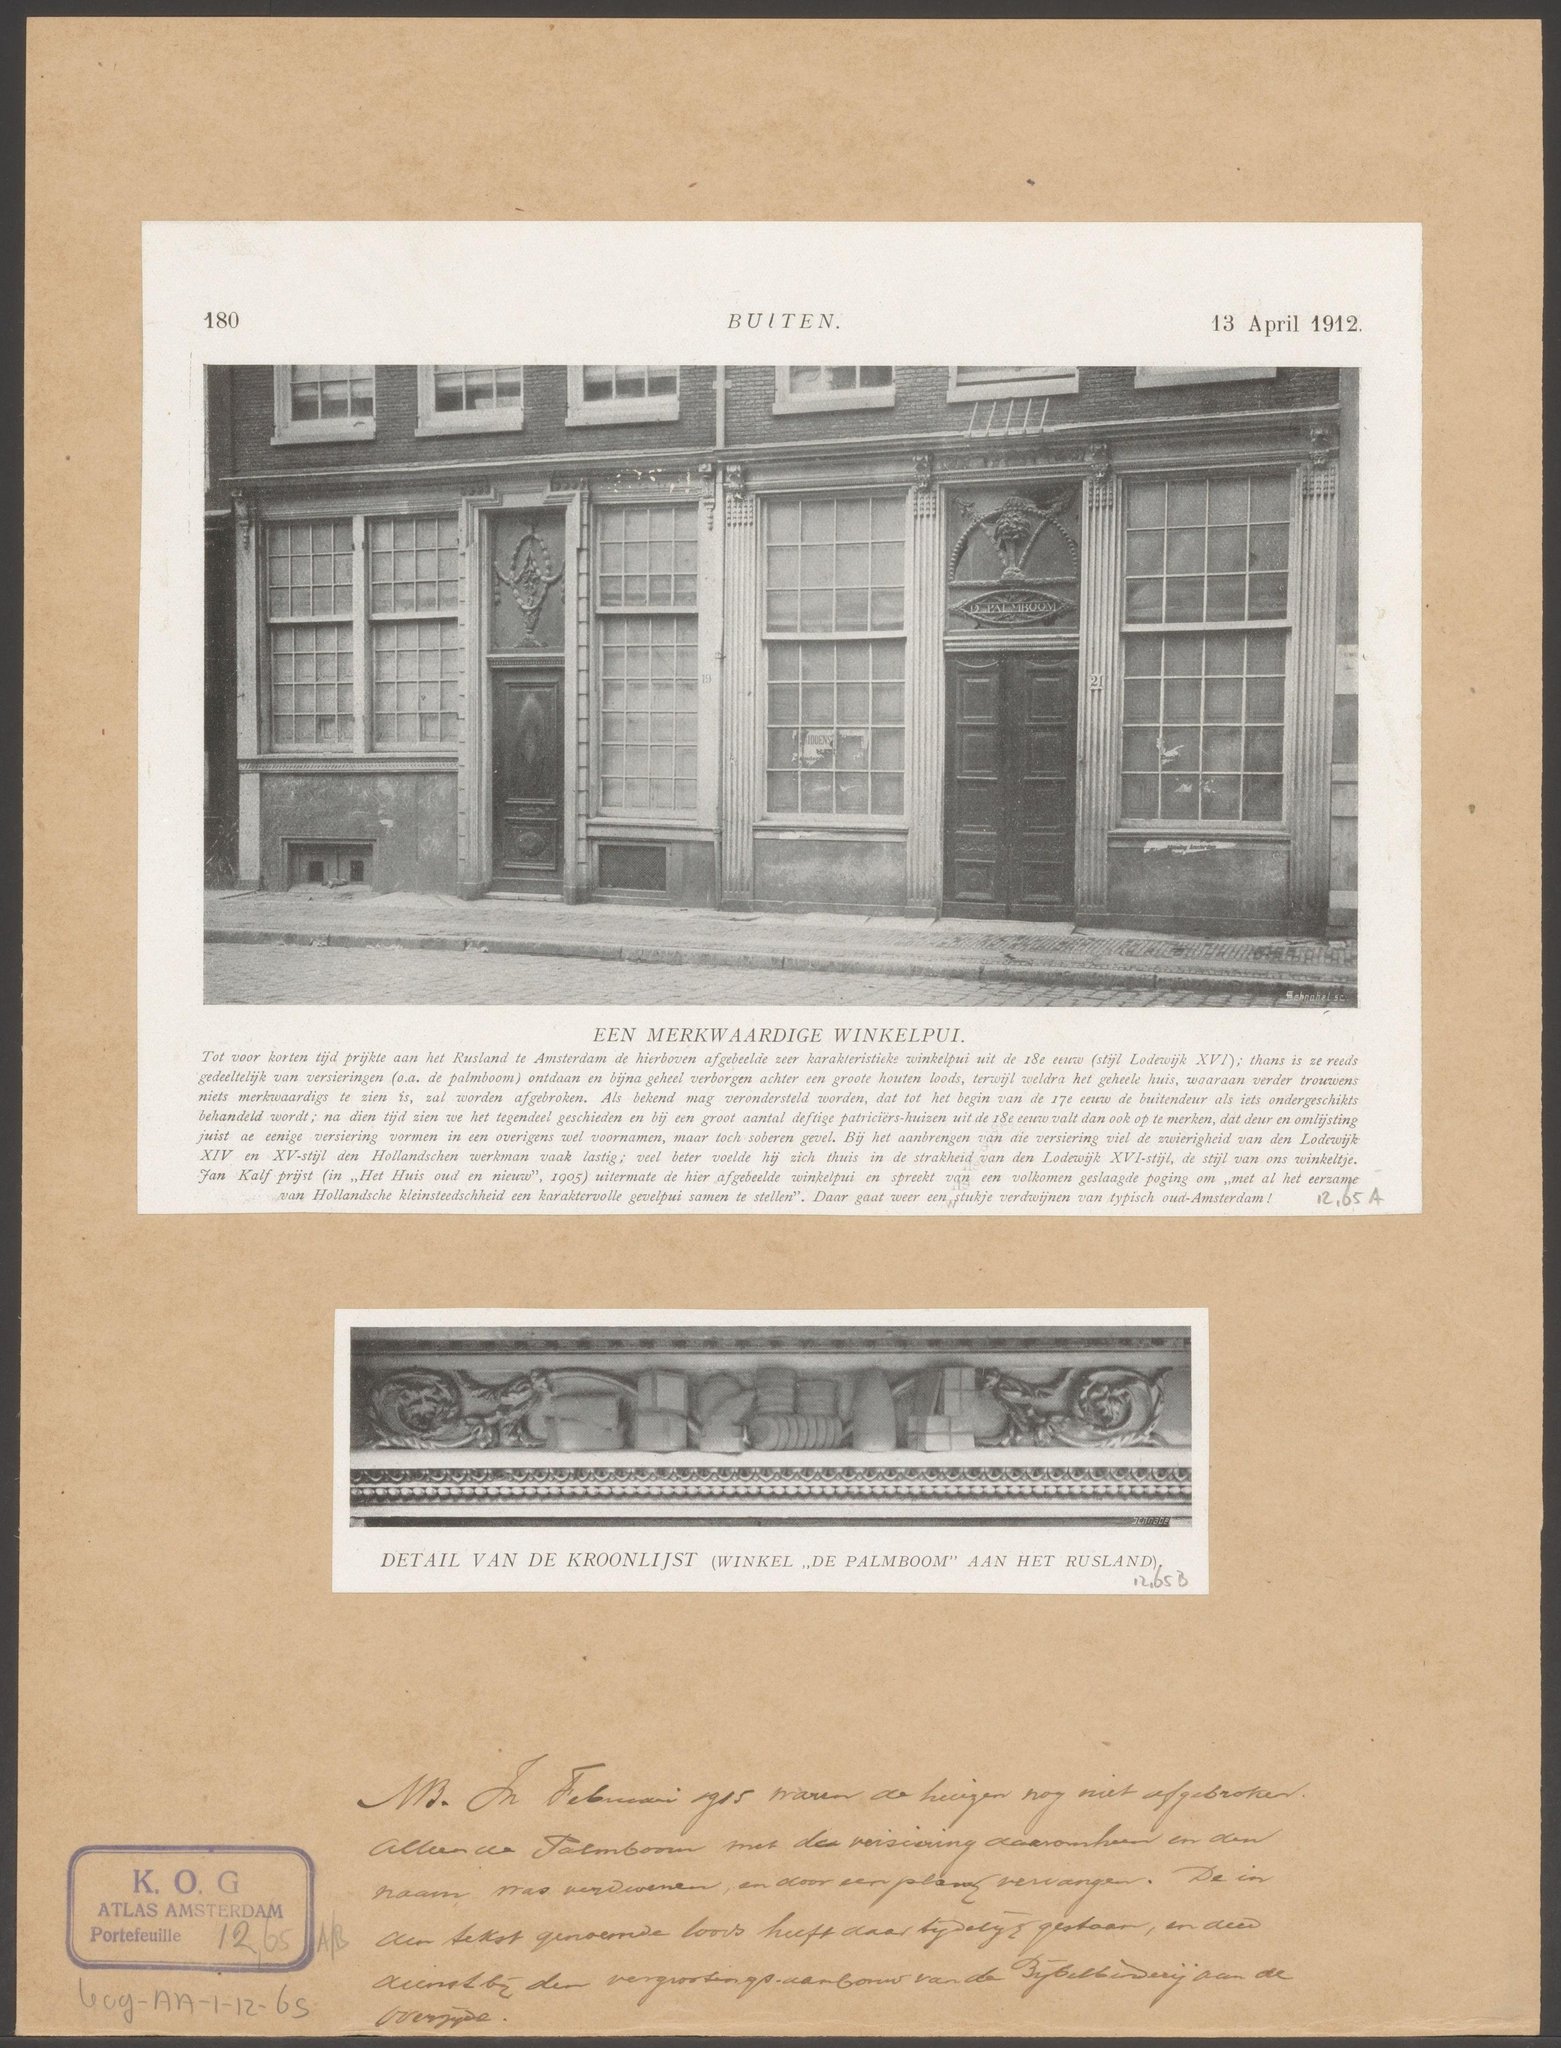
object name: photomechanical print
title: Gezicht op de gevel van winkel De Palmboom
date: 1912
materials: paper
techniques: letterpress printing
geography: amsterdam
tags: shop, store, city-view in general; 'veduta', façade (of house or building)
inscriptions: inscription: ‘[...] In februari (...) aan de / overzijde.’, collector's mark: ‘12,65’ Lugt 1641b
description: Onderwerpsrubriek binnen de Atlas Amsterdam: Rokin, Rotterdammersloot, Rozengang, Rozengracht, Rozenstraat, Rusland, Rustenburgerstraat, Ruysdaelkade, Ruysdaelstraat, Ruyterkade (de), Ruyterweg (Admiraal de).